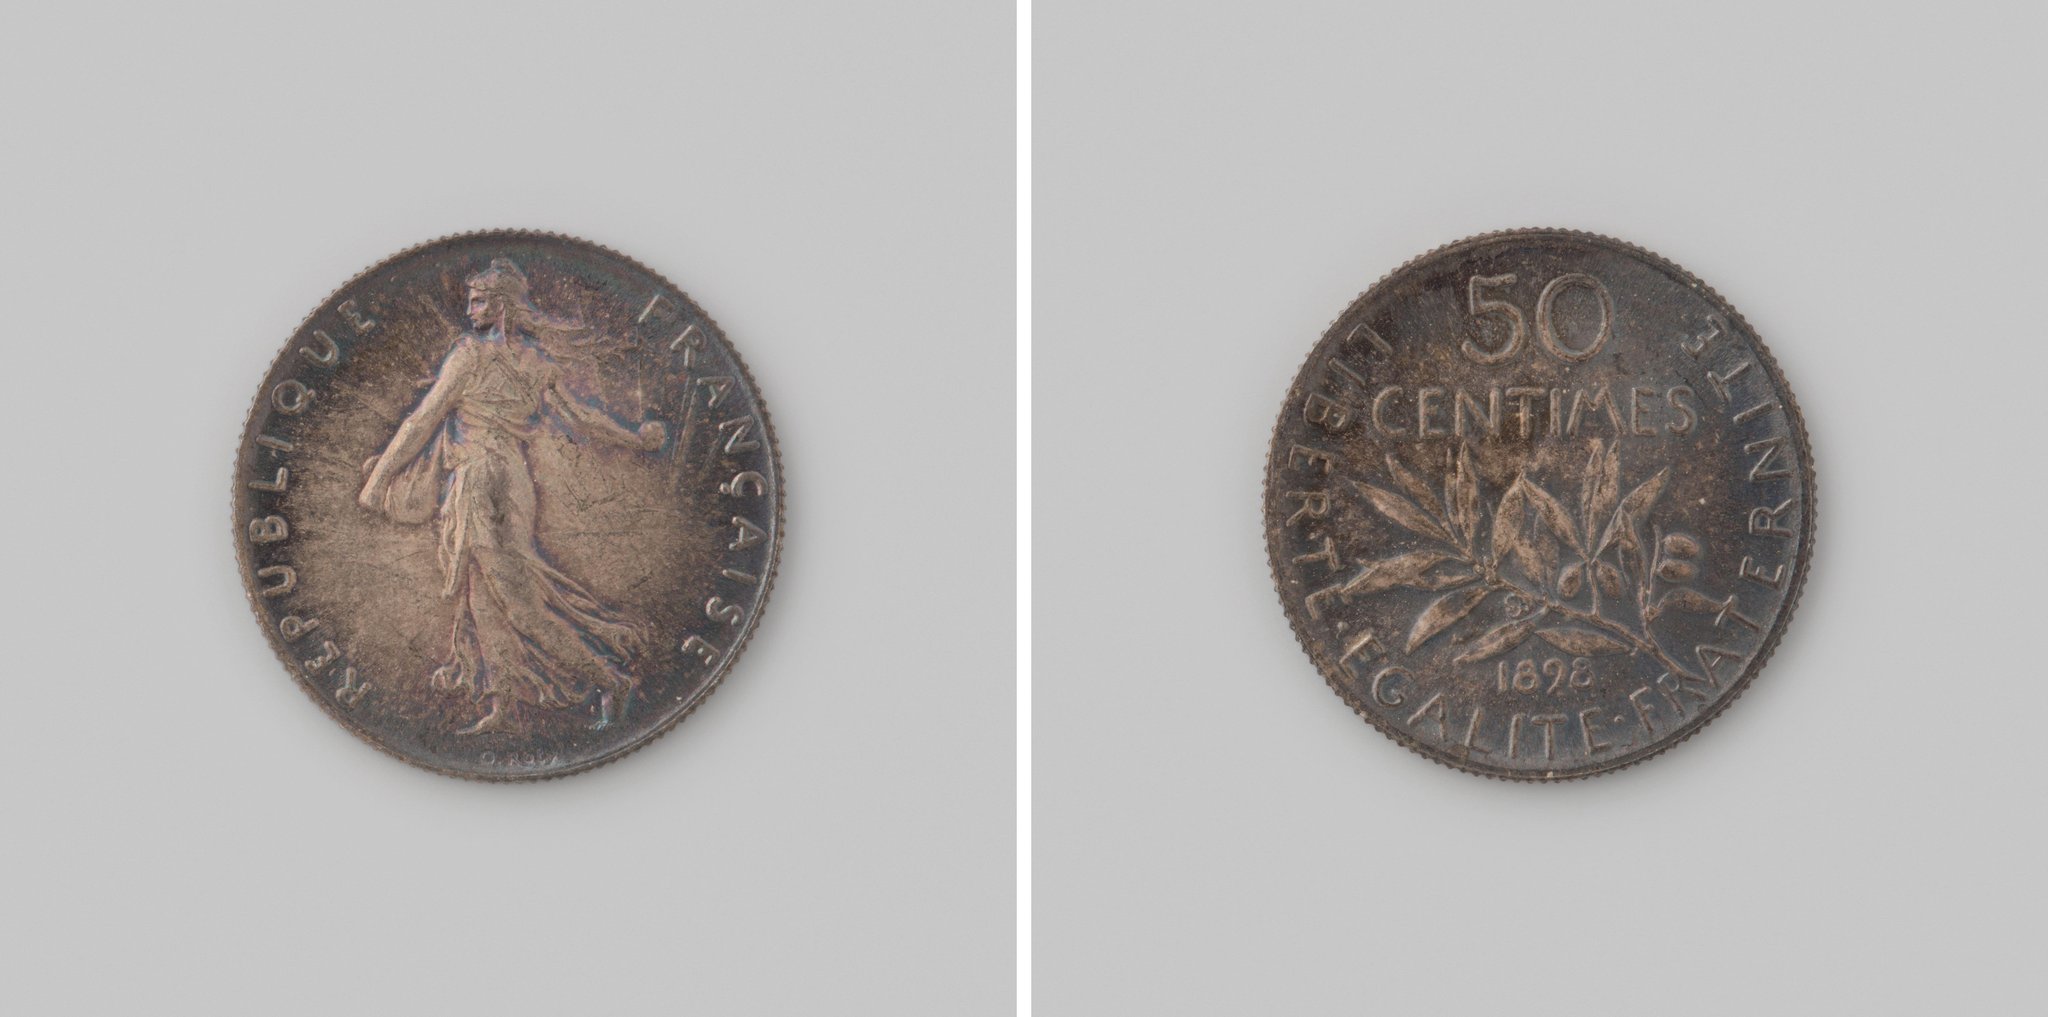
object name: coin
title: Frankrijk, Derde Republiek, 50 centimes, 1898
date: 1898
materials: silver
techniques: striking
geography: paris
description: Zilveren munt. Voorzijde: zaaiende vrouw met vrijheidshoed naar links met op achtergrond stralende zon. Keerzijde: waarde-aanduiding in twee regels, waaronder tak. Daaronder jaartal. Kartelrand.